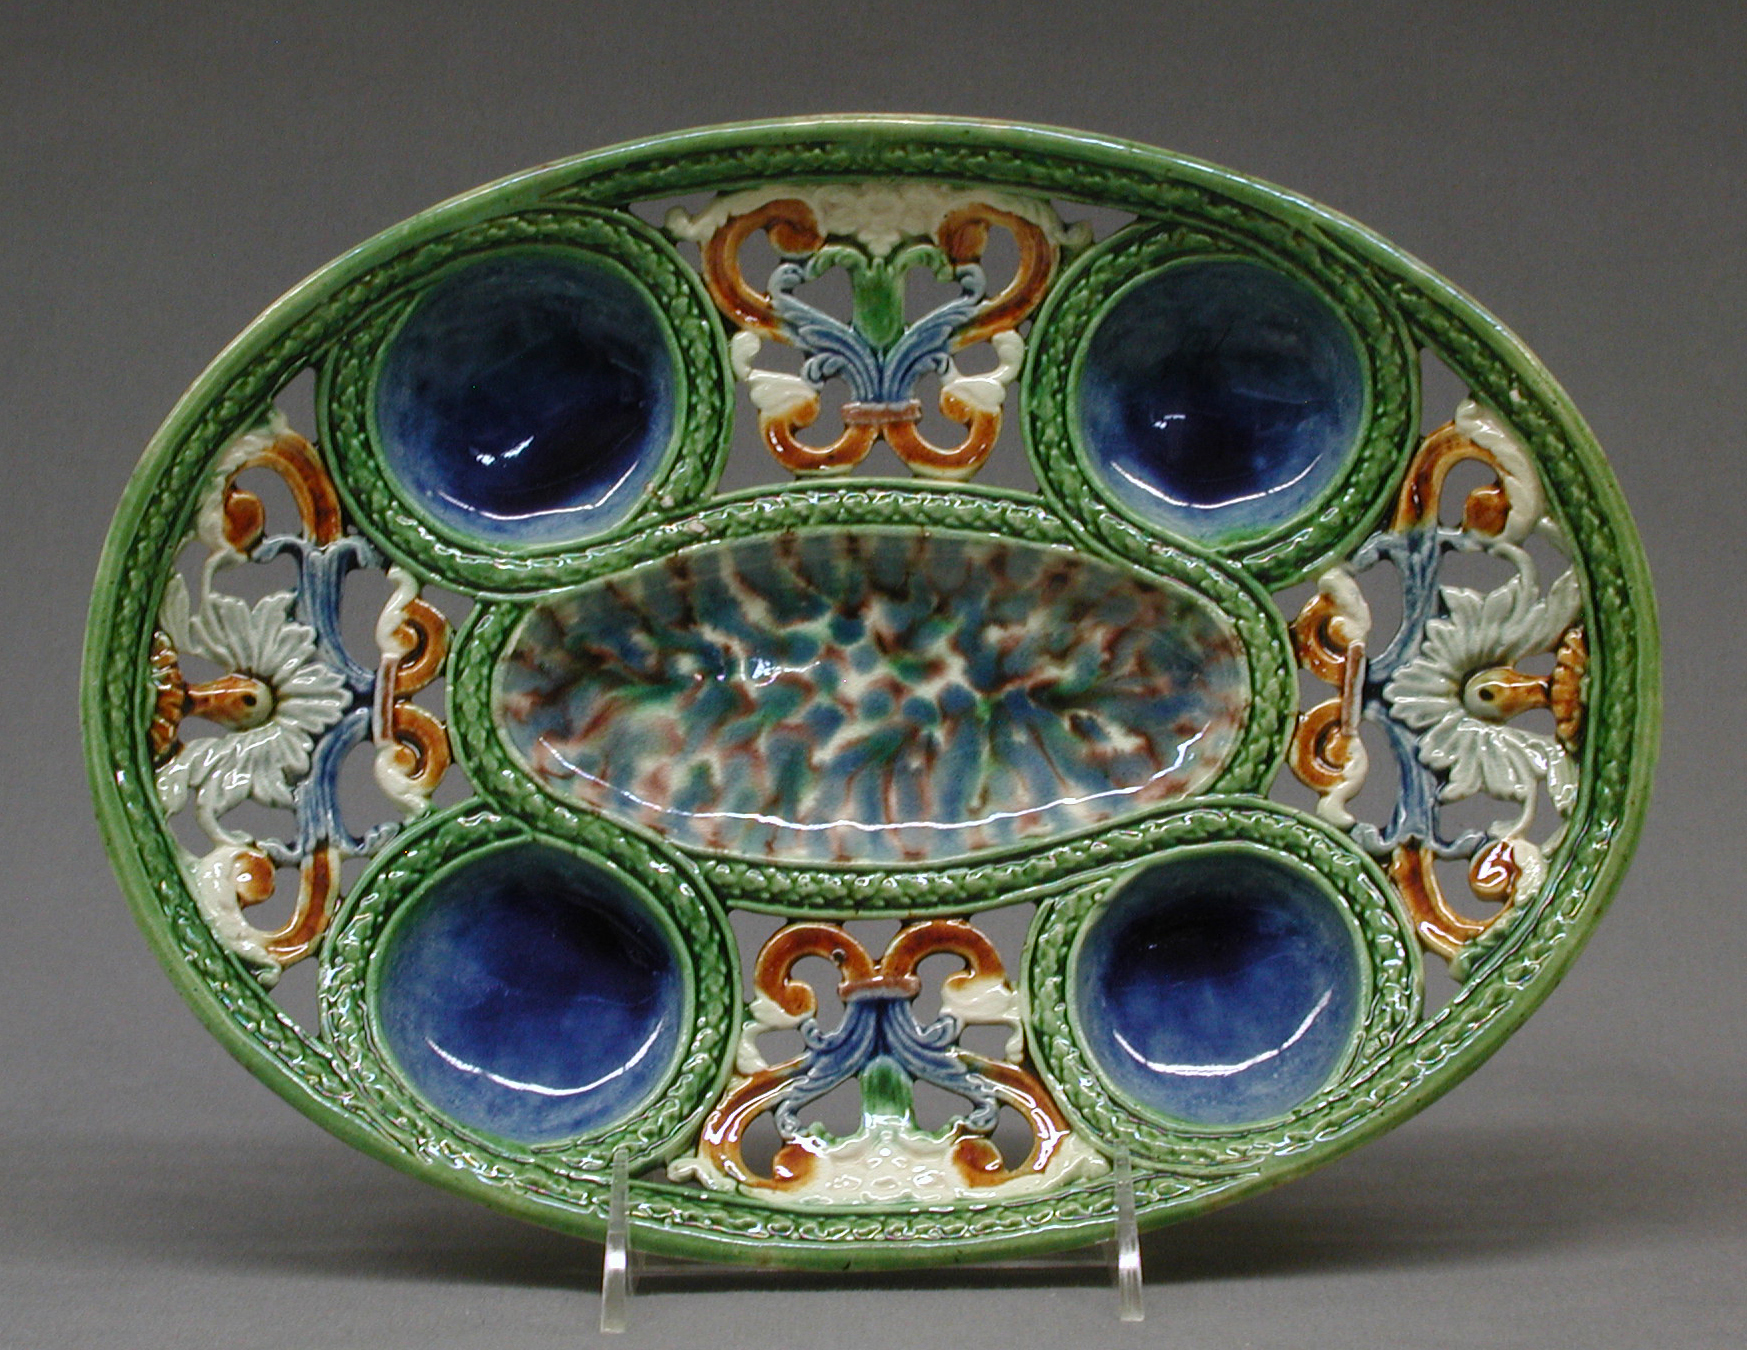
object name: dish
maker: bernard palissy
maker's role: maker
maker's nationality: french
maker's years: 1510-1590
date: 1601-1700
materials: earthenware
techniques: glazing